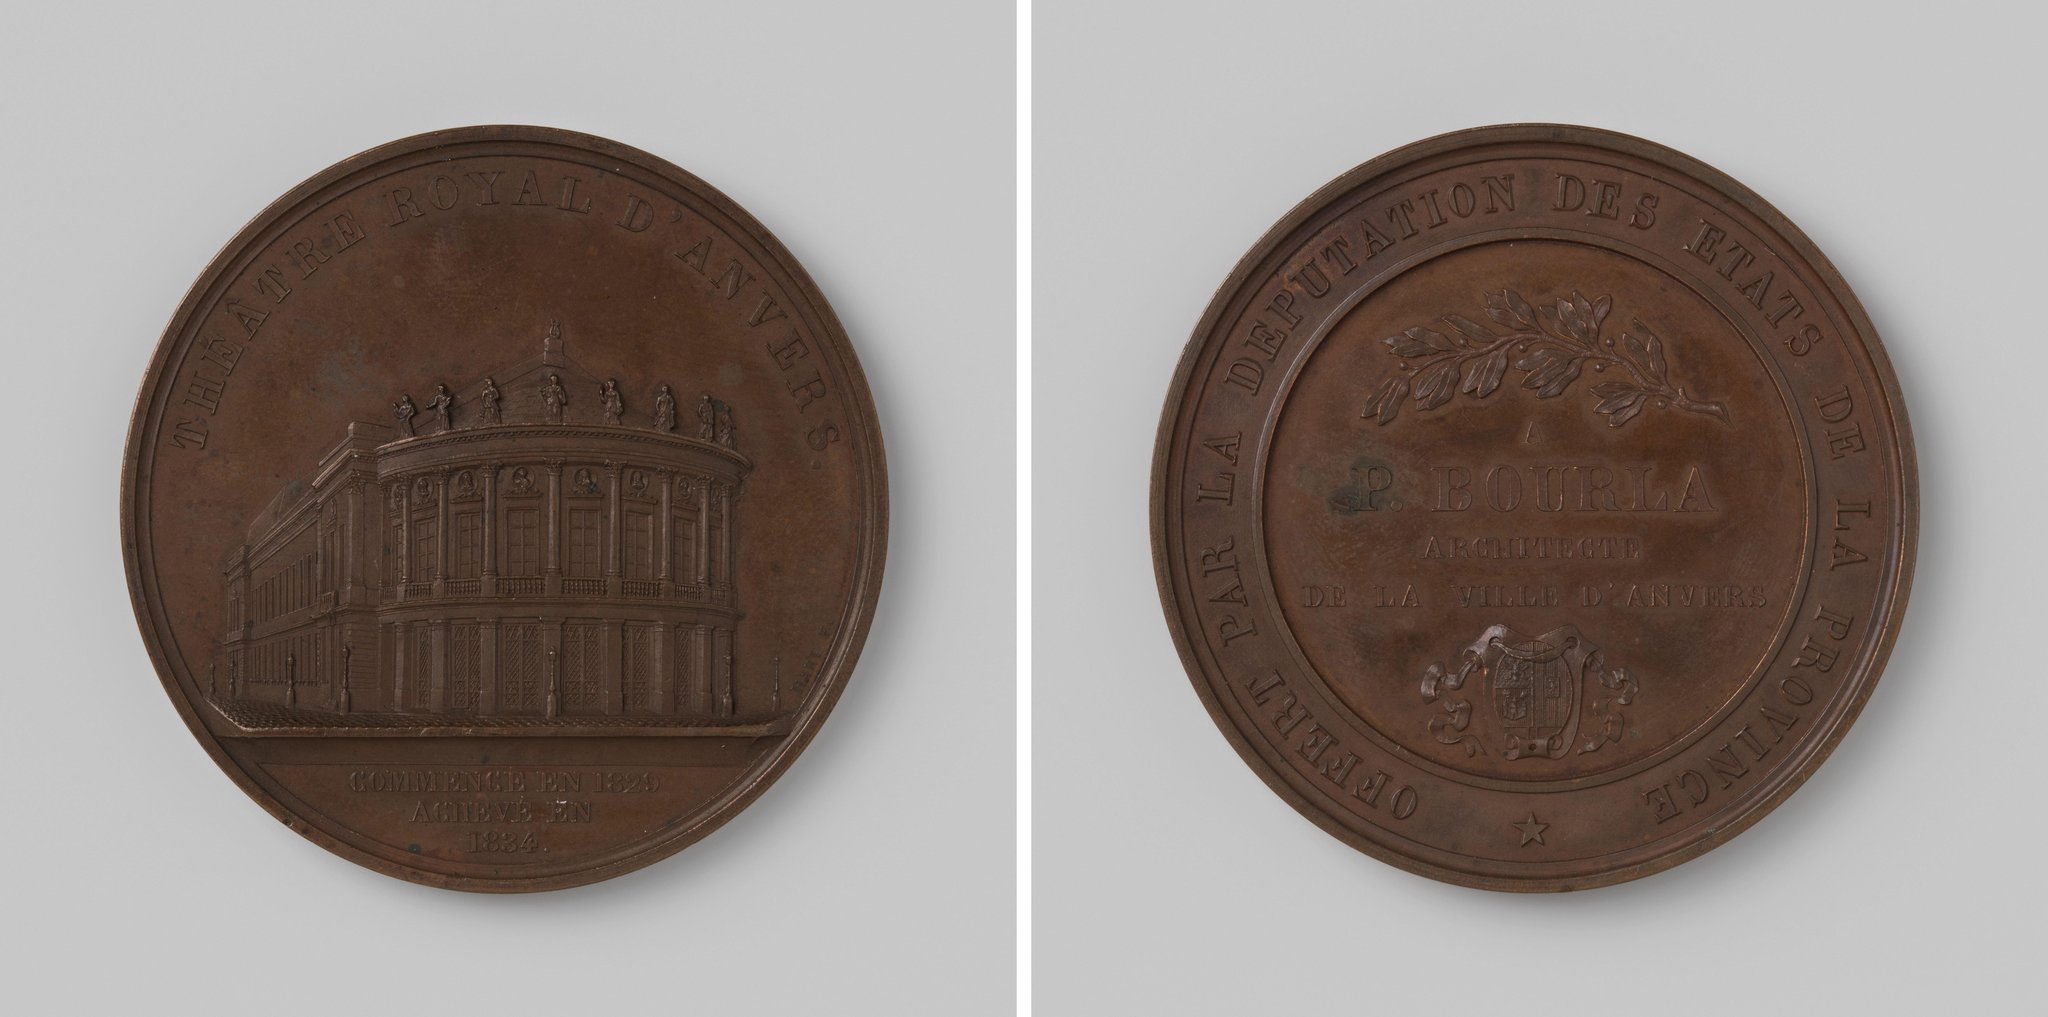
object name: history medal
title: Inwijding van het Theatre Royale van Antwerpen, penning door de Staten van Antwerpen aan de architect P. Bourla geschonken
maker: laurent joseph hart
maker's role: die cutter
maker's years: 1810-1860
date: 1834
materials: bronze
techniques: striking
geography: brussels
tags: antwerp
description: Bronzen penning. Voorzijde: theater binnen omschrift; afsnede: opschrift. Keerzijde: opschrift onderlauwertak en boven wapenschild binnen omschrift